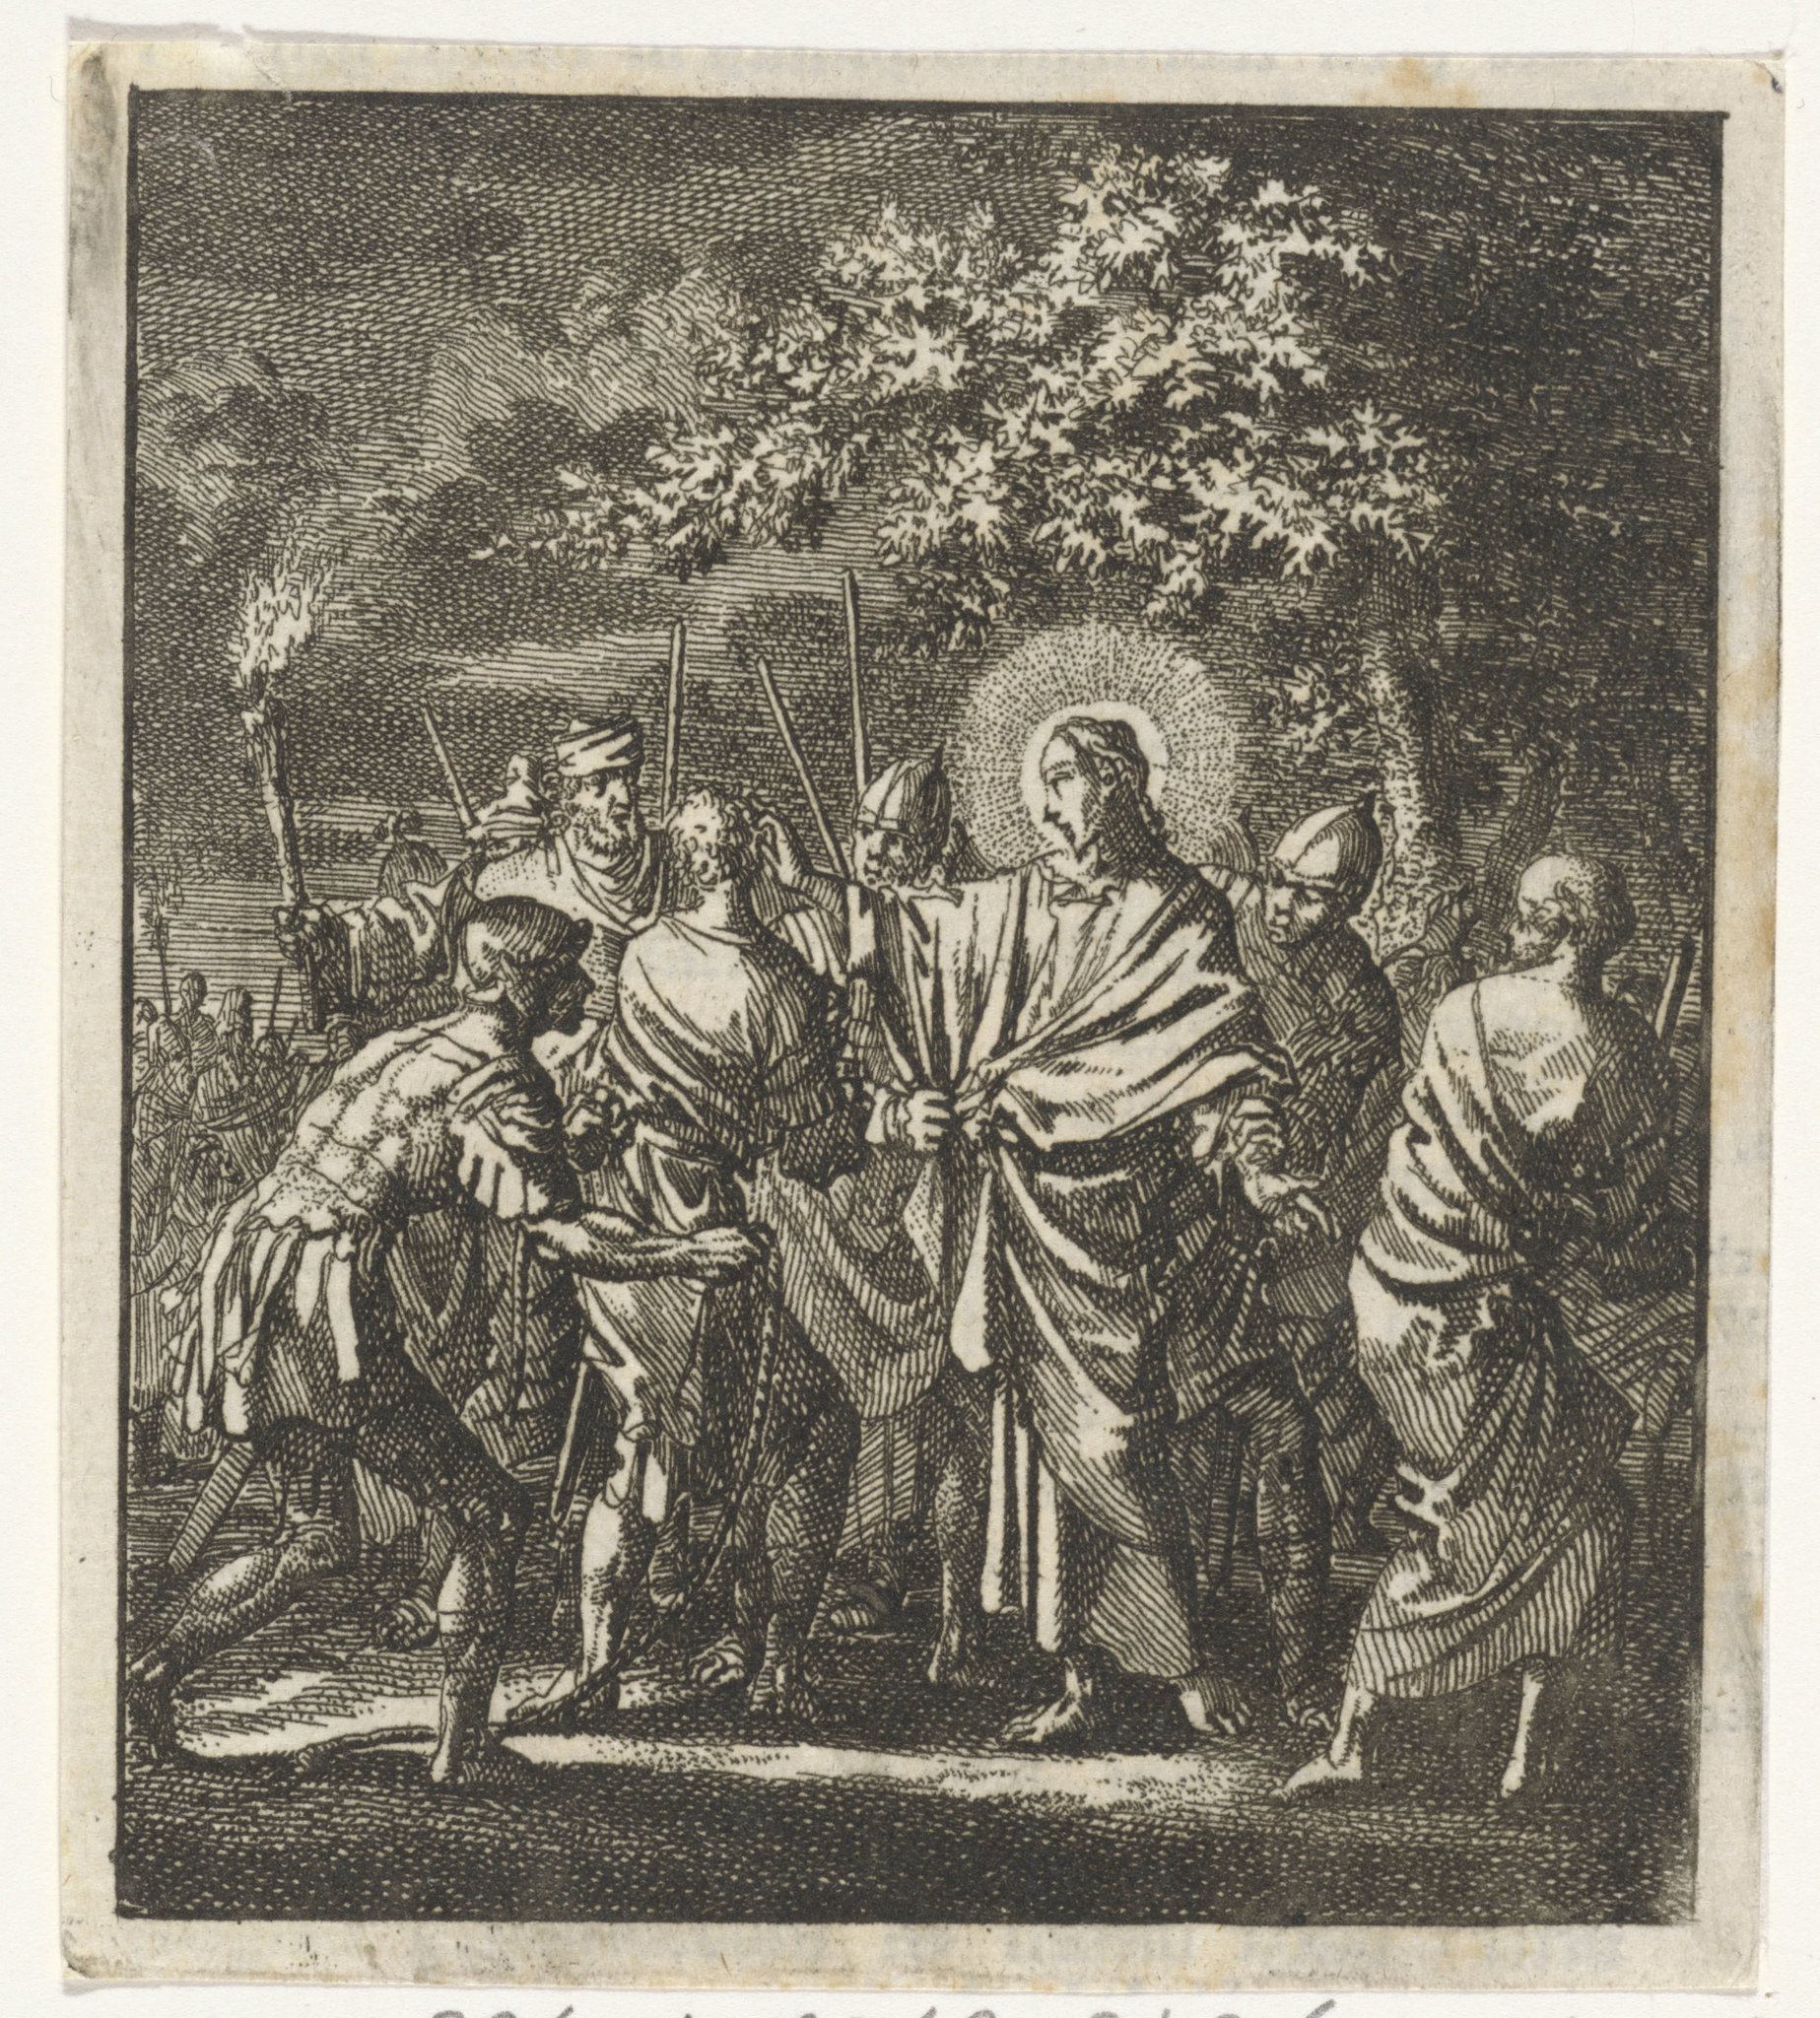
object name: book illustration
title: Christus gevangengenomen in de hof van Gethsemane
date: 1706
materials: paper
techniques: etching, letterpress printing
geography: amsterdam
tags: the arrest of christ ~ garden of gethsemane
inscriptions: collector's mark: Lugt 2228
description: Illustratie voor: Schabaalje, Jean Philipsz. De vermeerderde lust-hof des gemoeds. Amsterdam: Jan Rieuwertsz. (II) en Barent Visscher, 1706, p. 387.